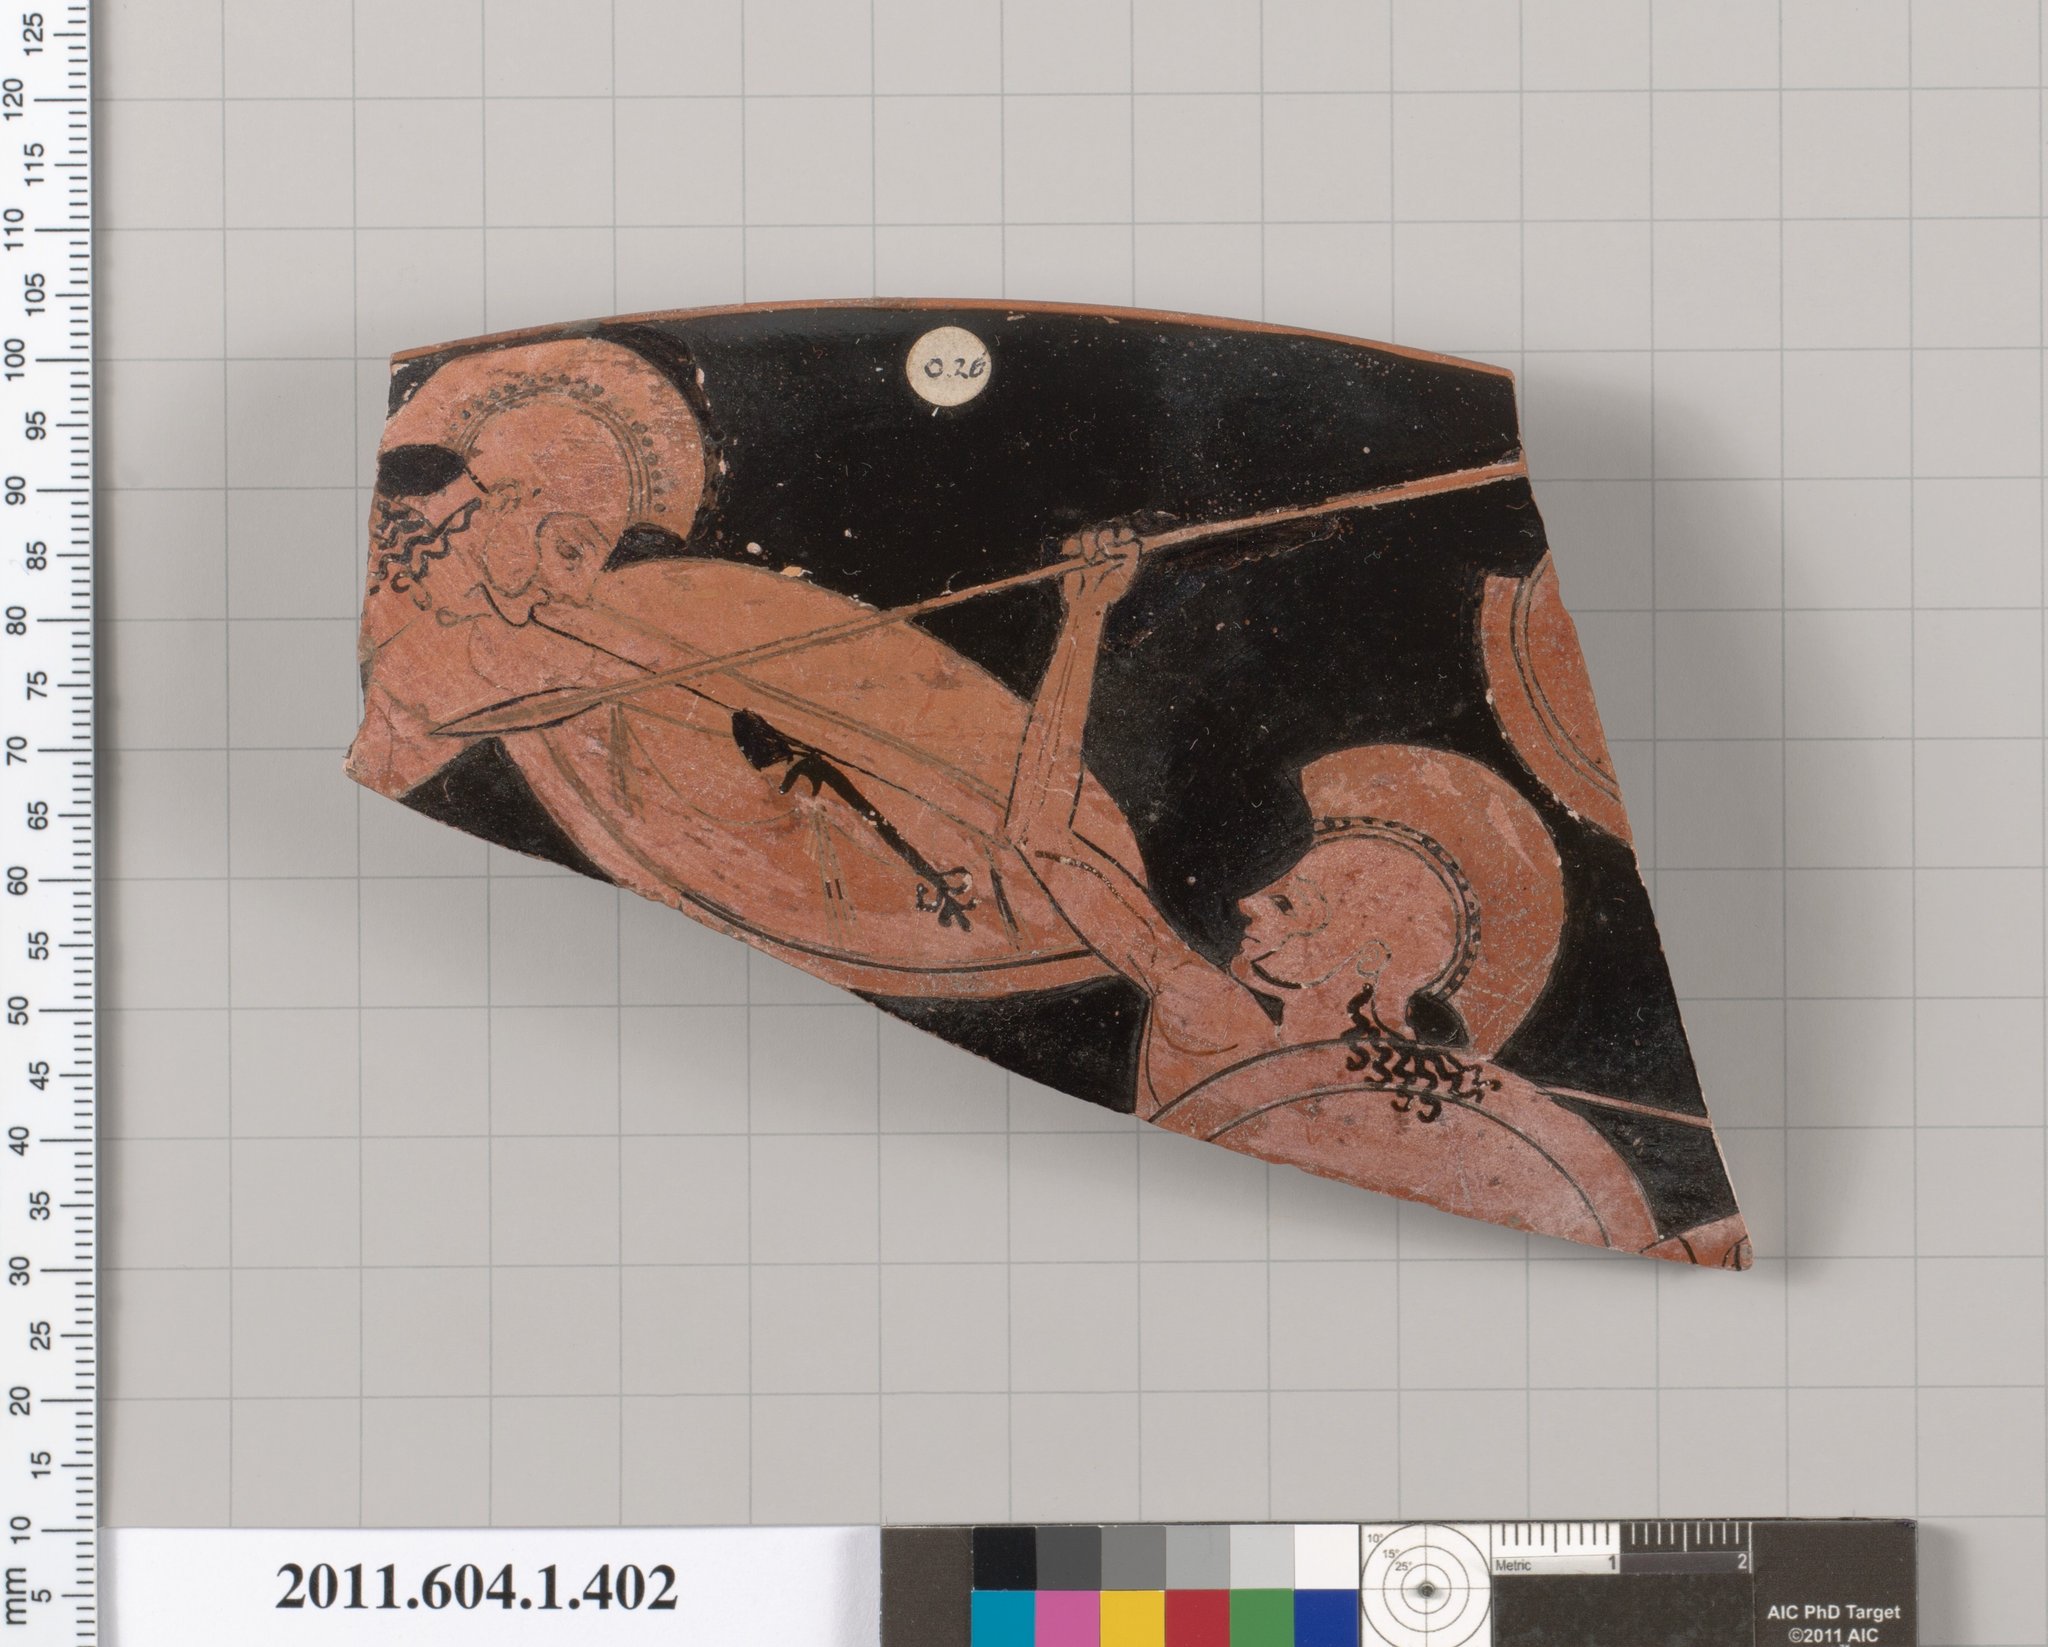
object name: kylix fragment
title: Terracotta rim fragment of a kylix (drinking cup)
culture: greek, attic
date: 475-451 BCE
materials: terracotta